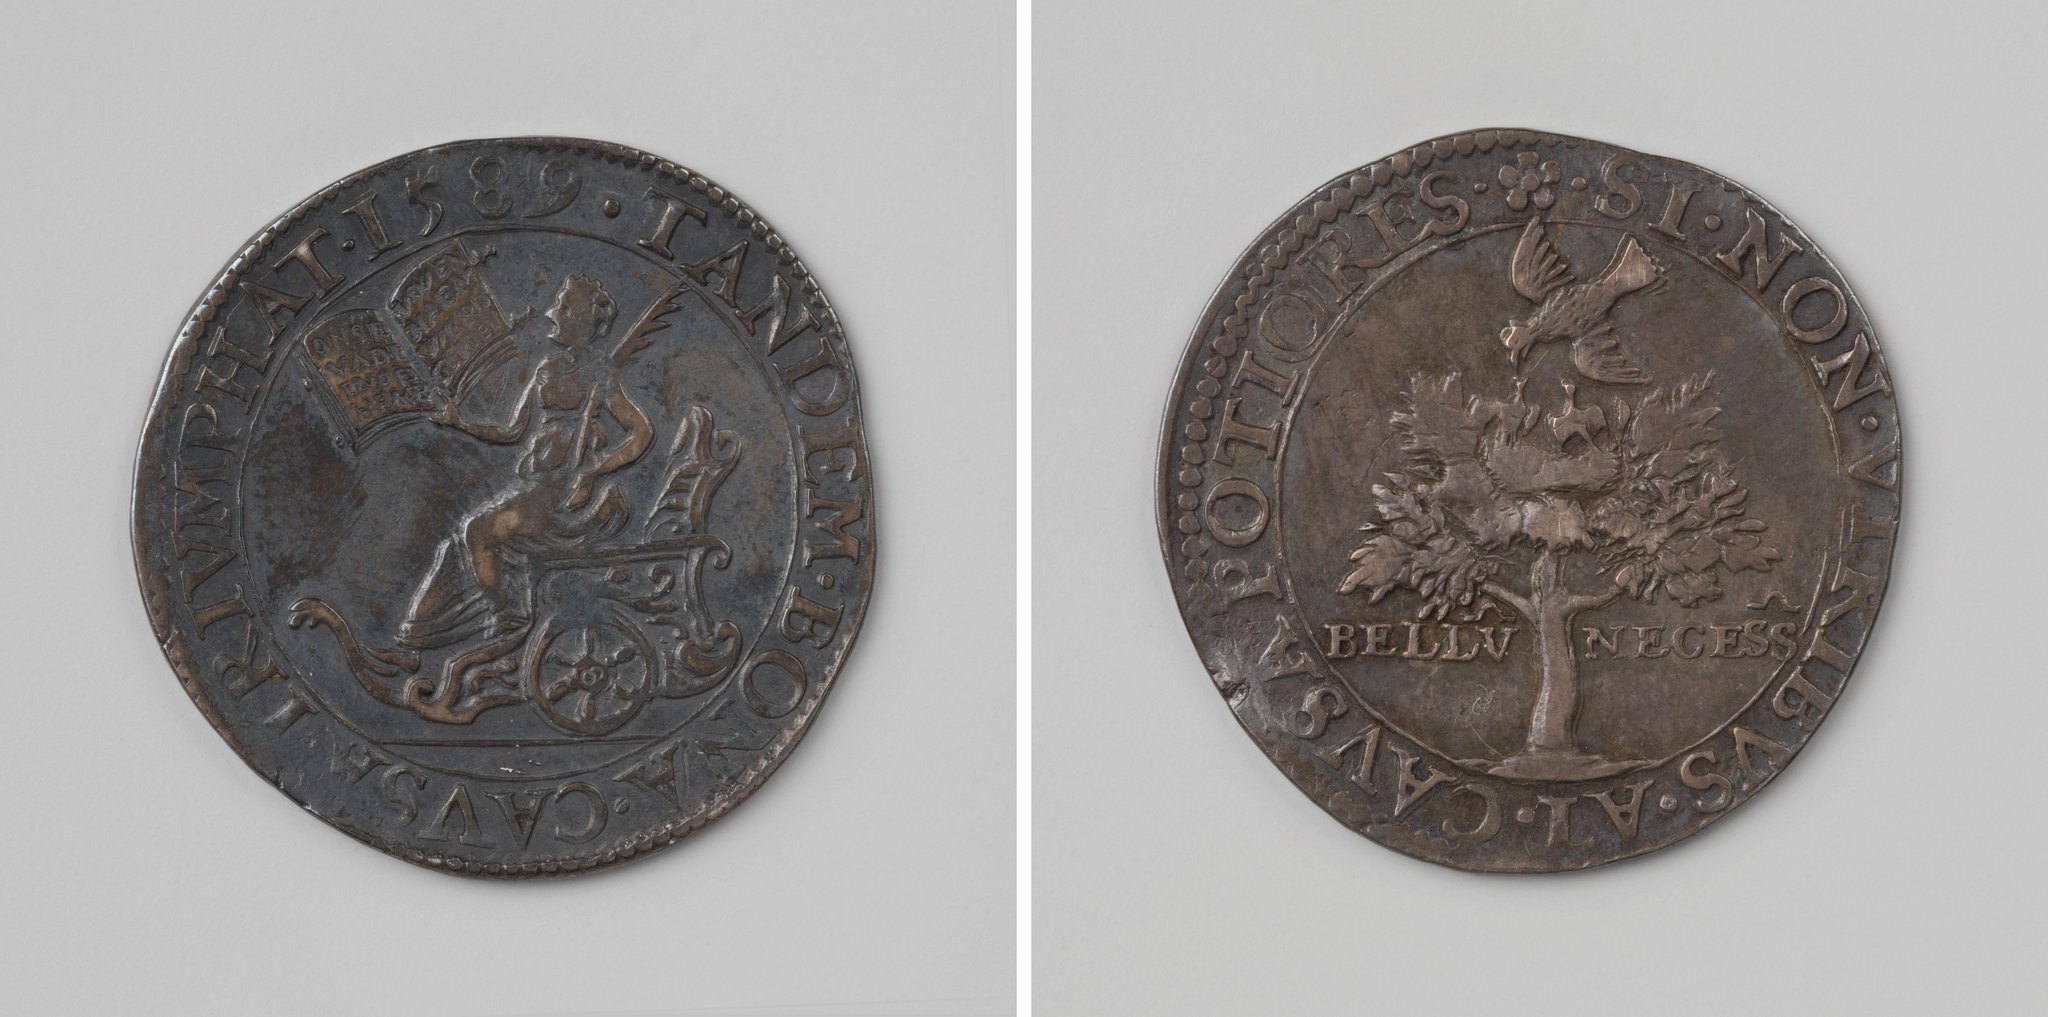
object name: jeton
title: Dankdag op het vergaan van de Spaanse armada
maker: Anonymous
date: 1589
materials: silver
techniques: striking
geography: dordrecht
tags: tachtigjarige oorlog, vergaan van de spaanse armada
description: Zilveren penning. Voorzijde: vrouw met geopend boek met opschrift in rechter- en palmtak in linkerhand, zittend in zegekar binnen omschrift. Keerzijde: nest met twee kleine vogels in boom, die zich gezamelijk verdedigen tegen grote vogel tussen opschrift binnen omschrift